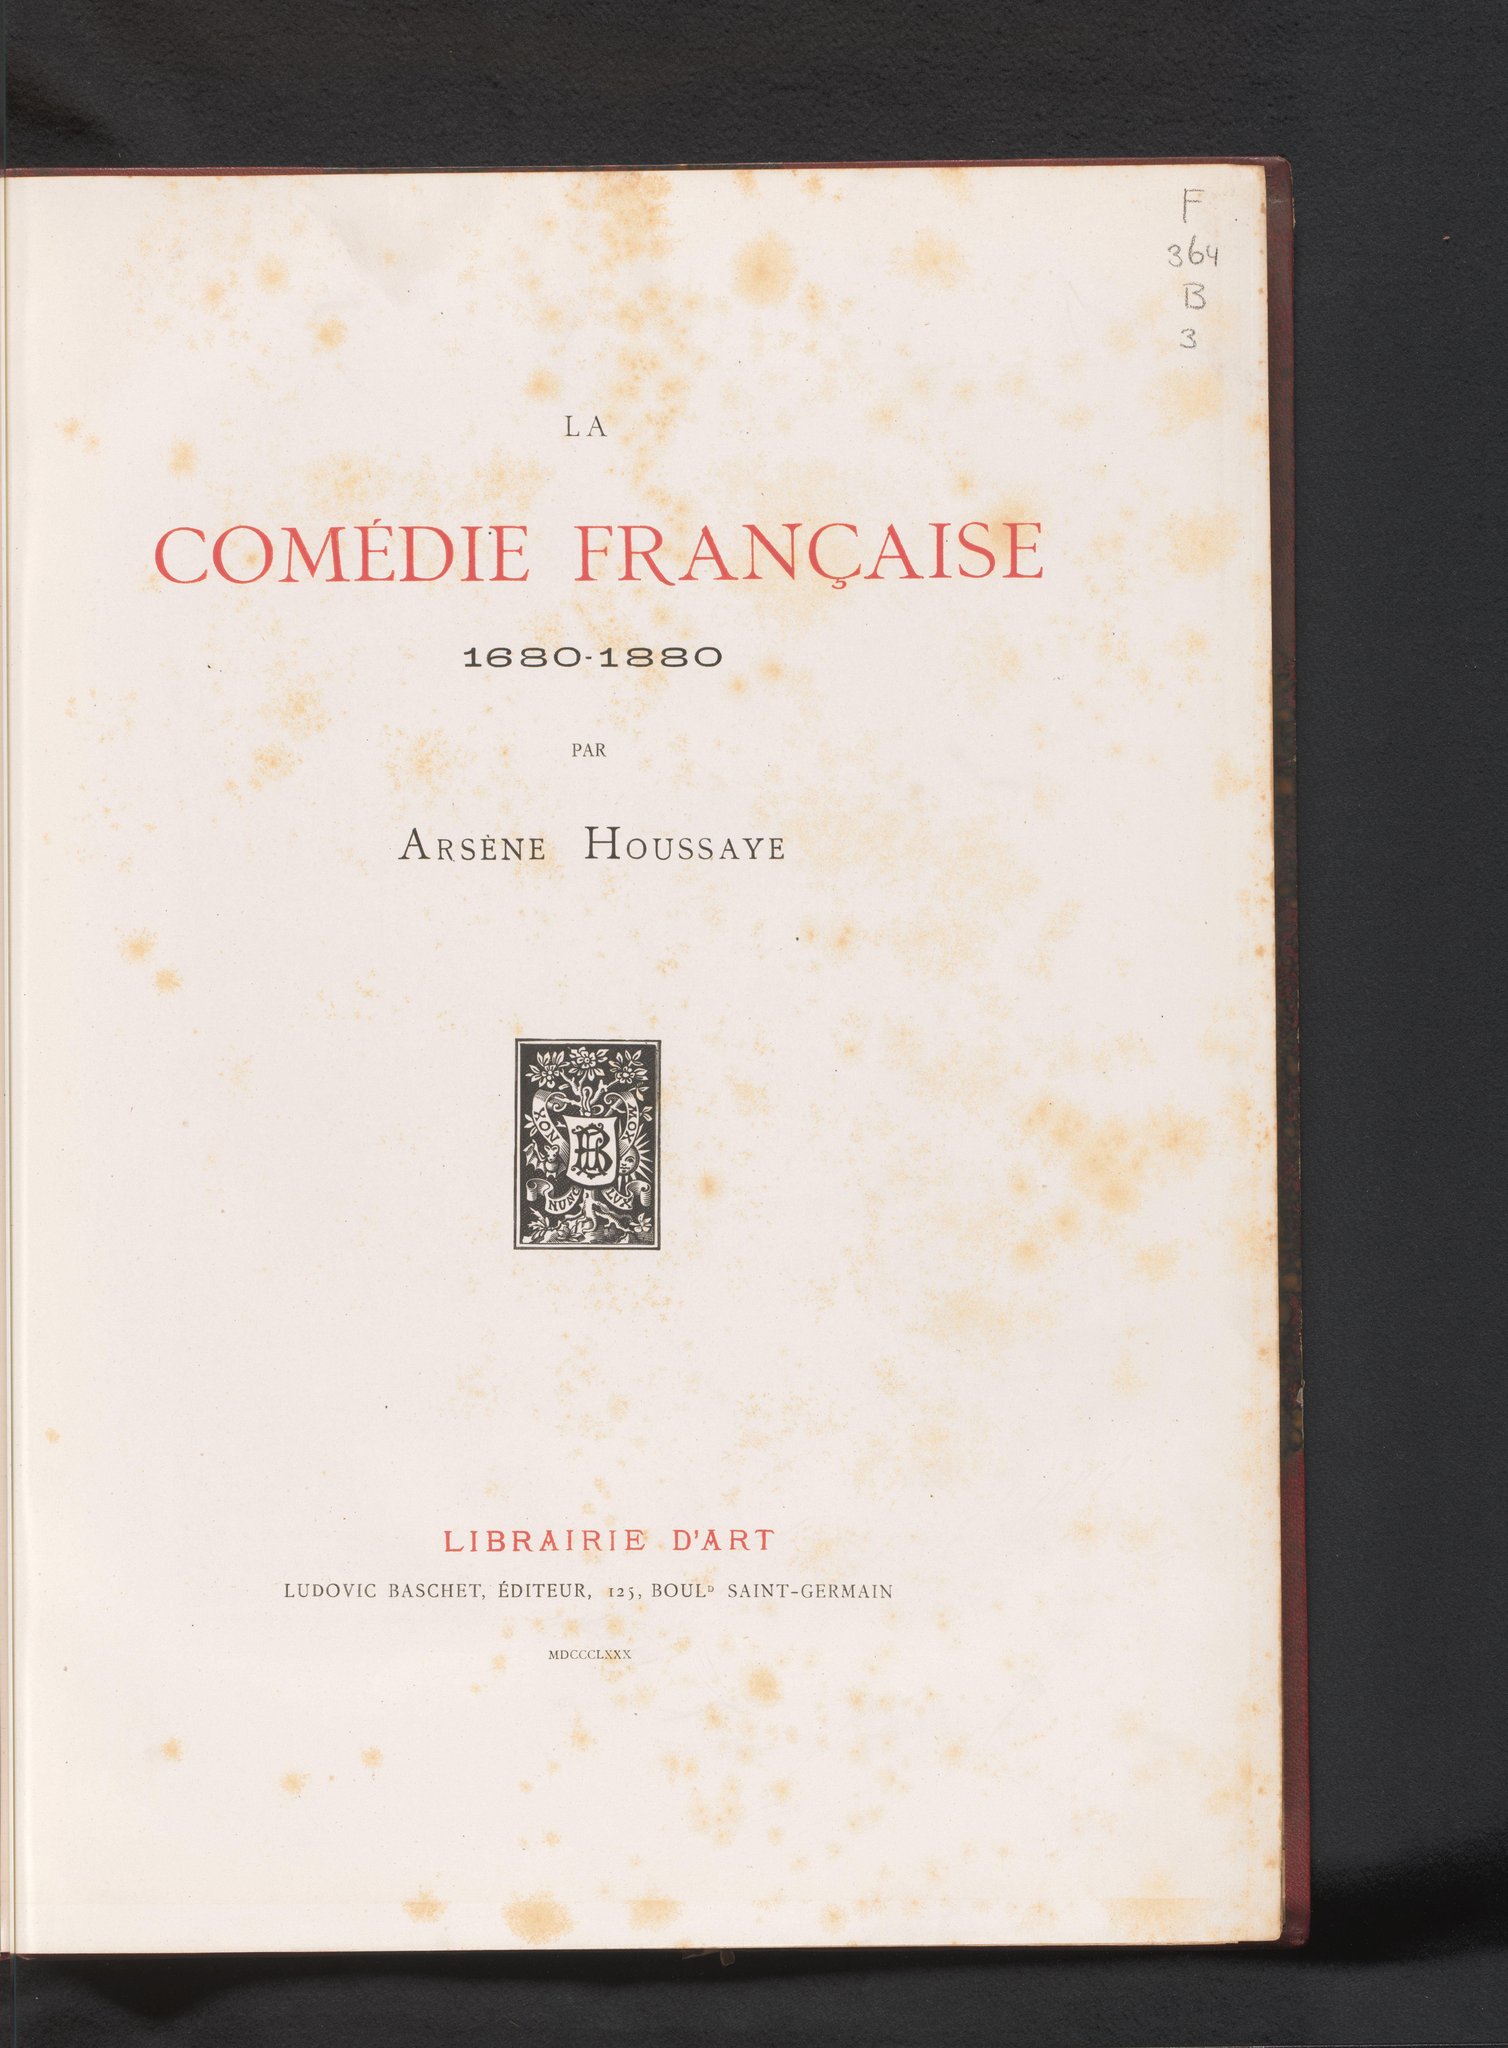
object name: book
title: La Comédie française 1680-1880 / par Arsène Houssaye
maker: ludovic baschet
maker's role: publisher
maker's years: 1834-1909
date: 1880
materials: cardboard, leather, linen, paper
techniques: marbled paper, photograph, printing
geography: paris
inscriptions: annotation: ‘1er tirage/ Reliare signie’, date: ‘FEB/ 1994’